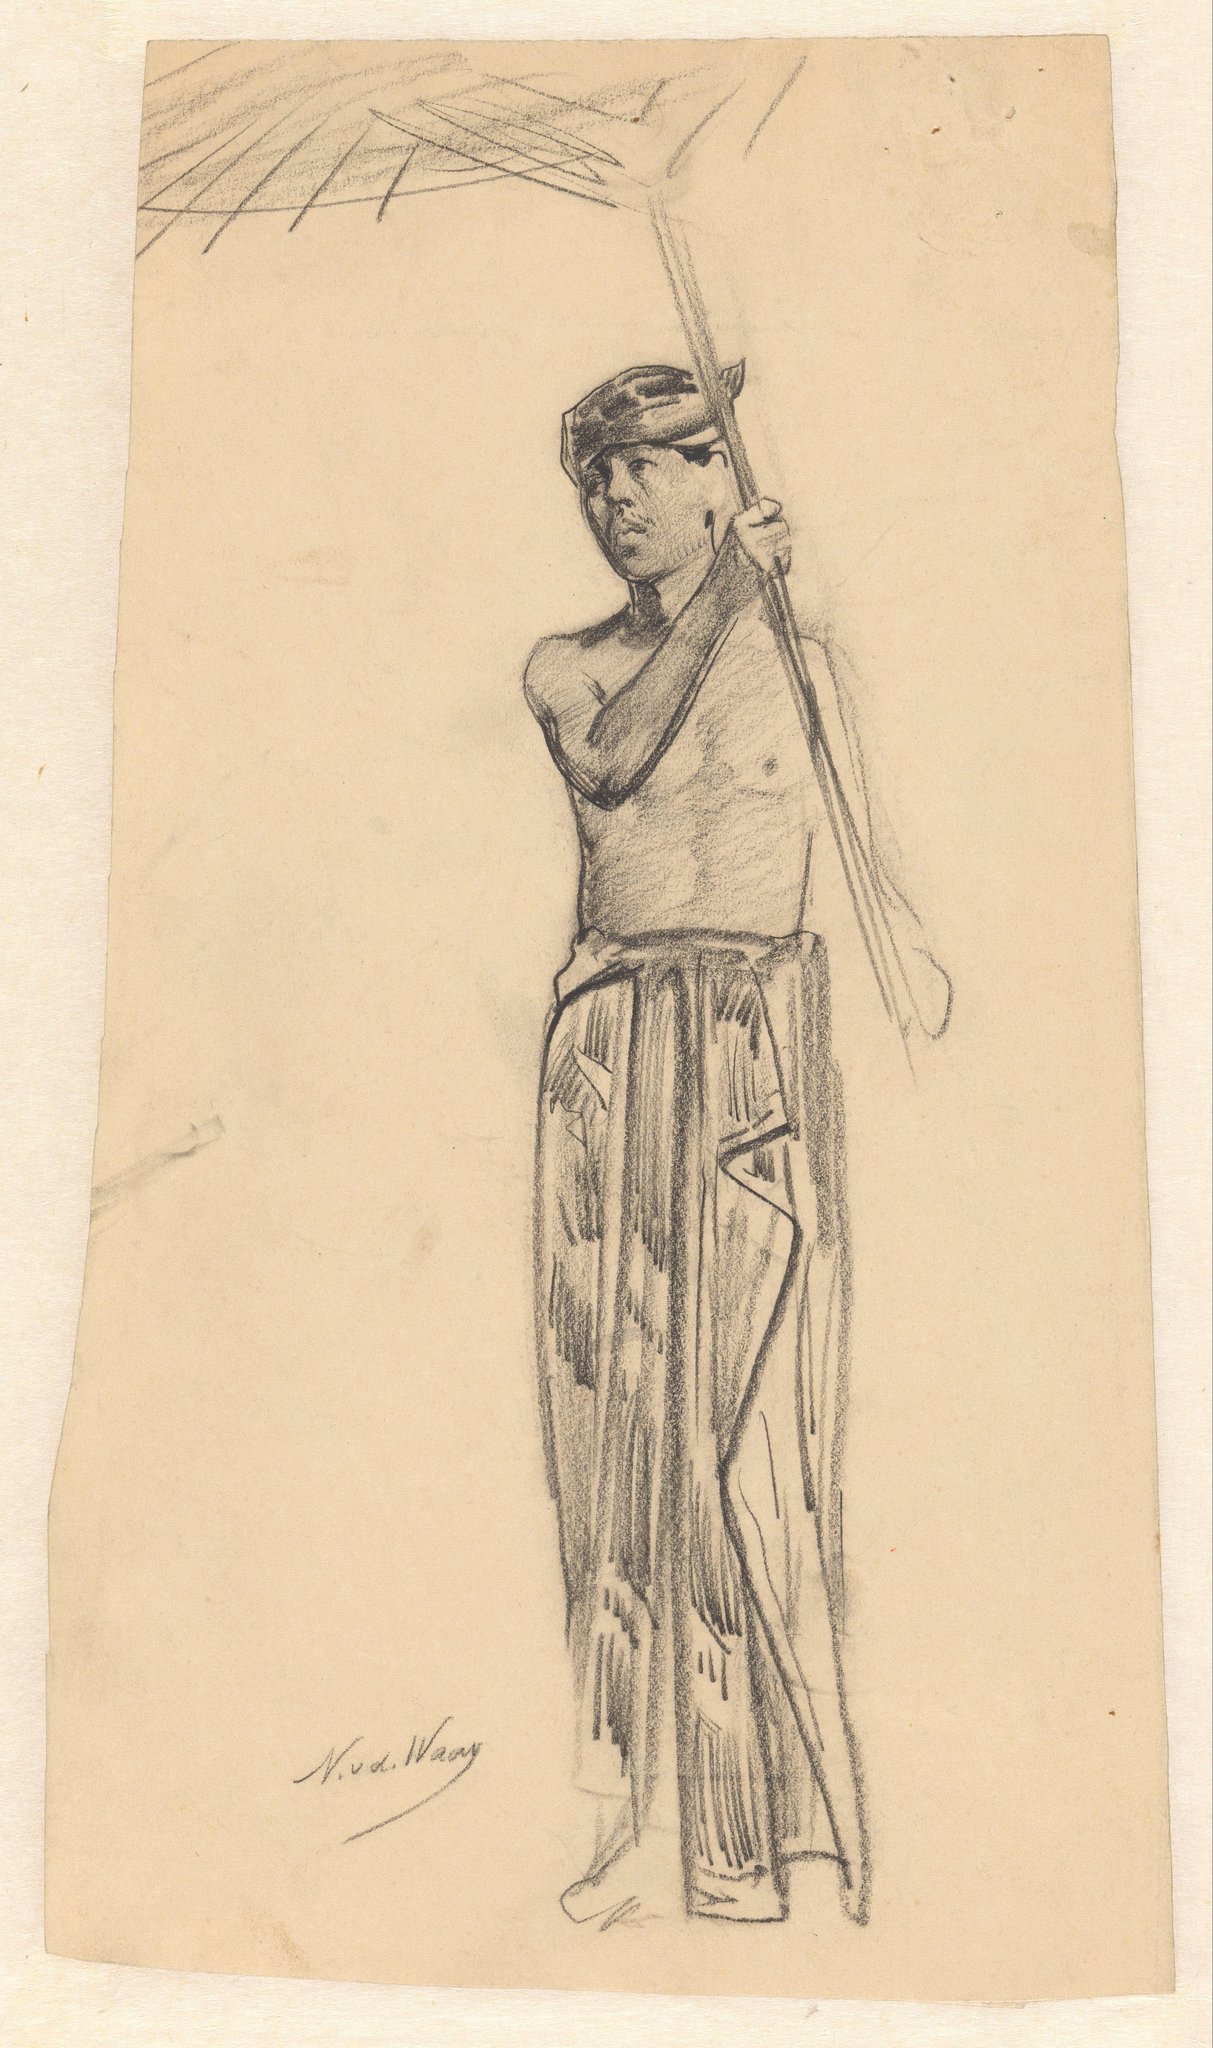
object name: drawing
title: Man uit Nederlands-Indië met pajong (parasol)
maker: nicolaas van der waay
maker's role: draughtsman, painter, print maker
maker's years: 1855-1936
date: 1898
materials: chalk, paper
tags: standing figure, parasol, sunshade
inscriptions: number: ‘973’, collector's mark: Lugt 2760, annotation: ‘AJ 157/30’, collector's mark: Lugt 2228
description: De tekening is vermoedelijk een voorstudie voor een deel van de voorstelling op het linkerpaneel van de Gouden Koets. Dit is het paneel waarop het eerbetoon aan koningin Wilhelmina van de toenmalige koloniën Oost- en West-Indië is geschilderd. Het betreft het deel waar een man een pajong vasthoudt rechts van de Nederlandse Maagd. Volgens het inventarisboek gaat het om een Javaanse man.